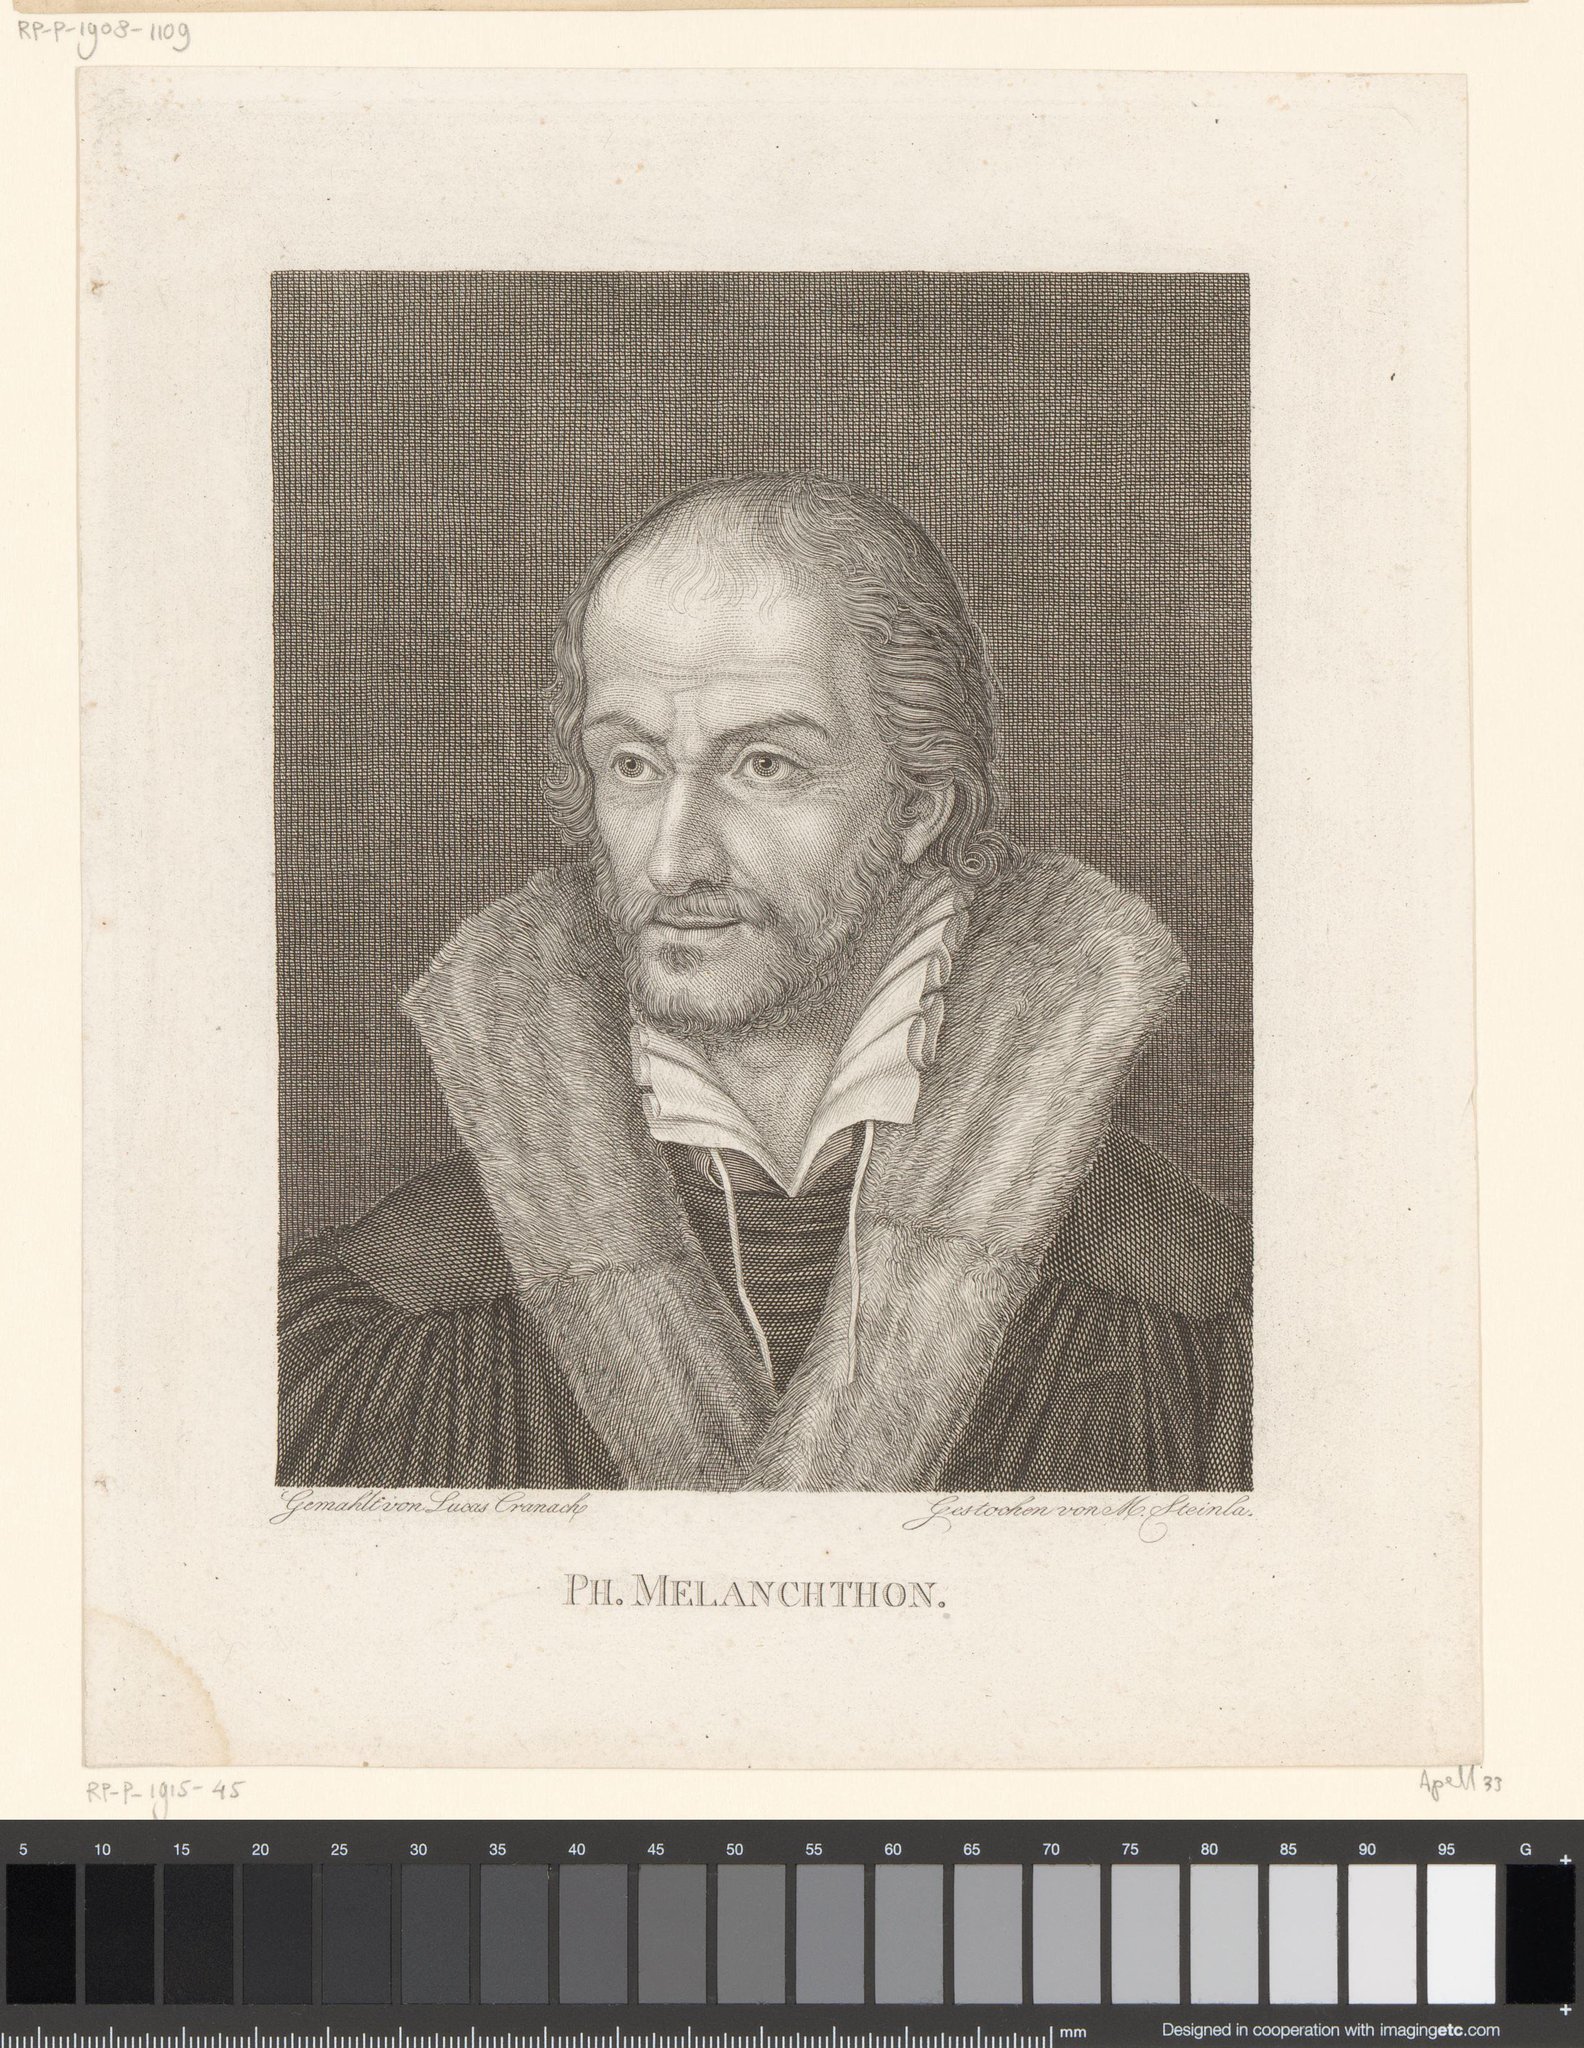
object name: print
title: Portret van Philipp Melanchton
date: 1818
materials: paper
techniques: engraving, etching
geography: germany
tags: historical persons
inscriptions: collector's mark: Lugt 2228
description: Prent gebruikt voor de publicatie: Jacobi, Johann Adolph. Eichenlaub, auf Luthers Grab gestreut im Jahre 1817. Erfurt en Gotha: Henning Buchhandlung, 1818.